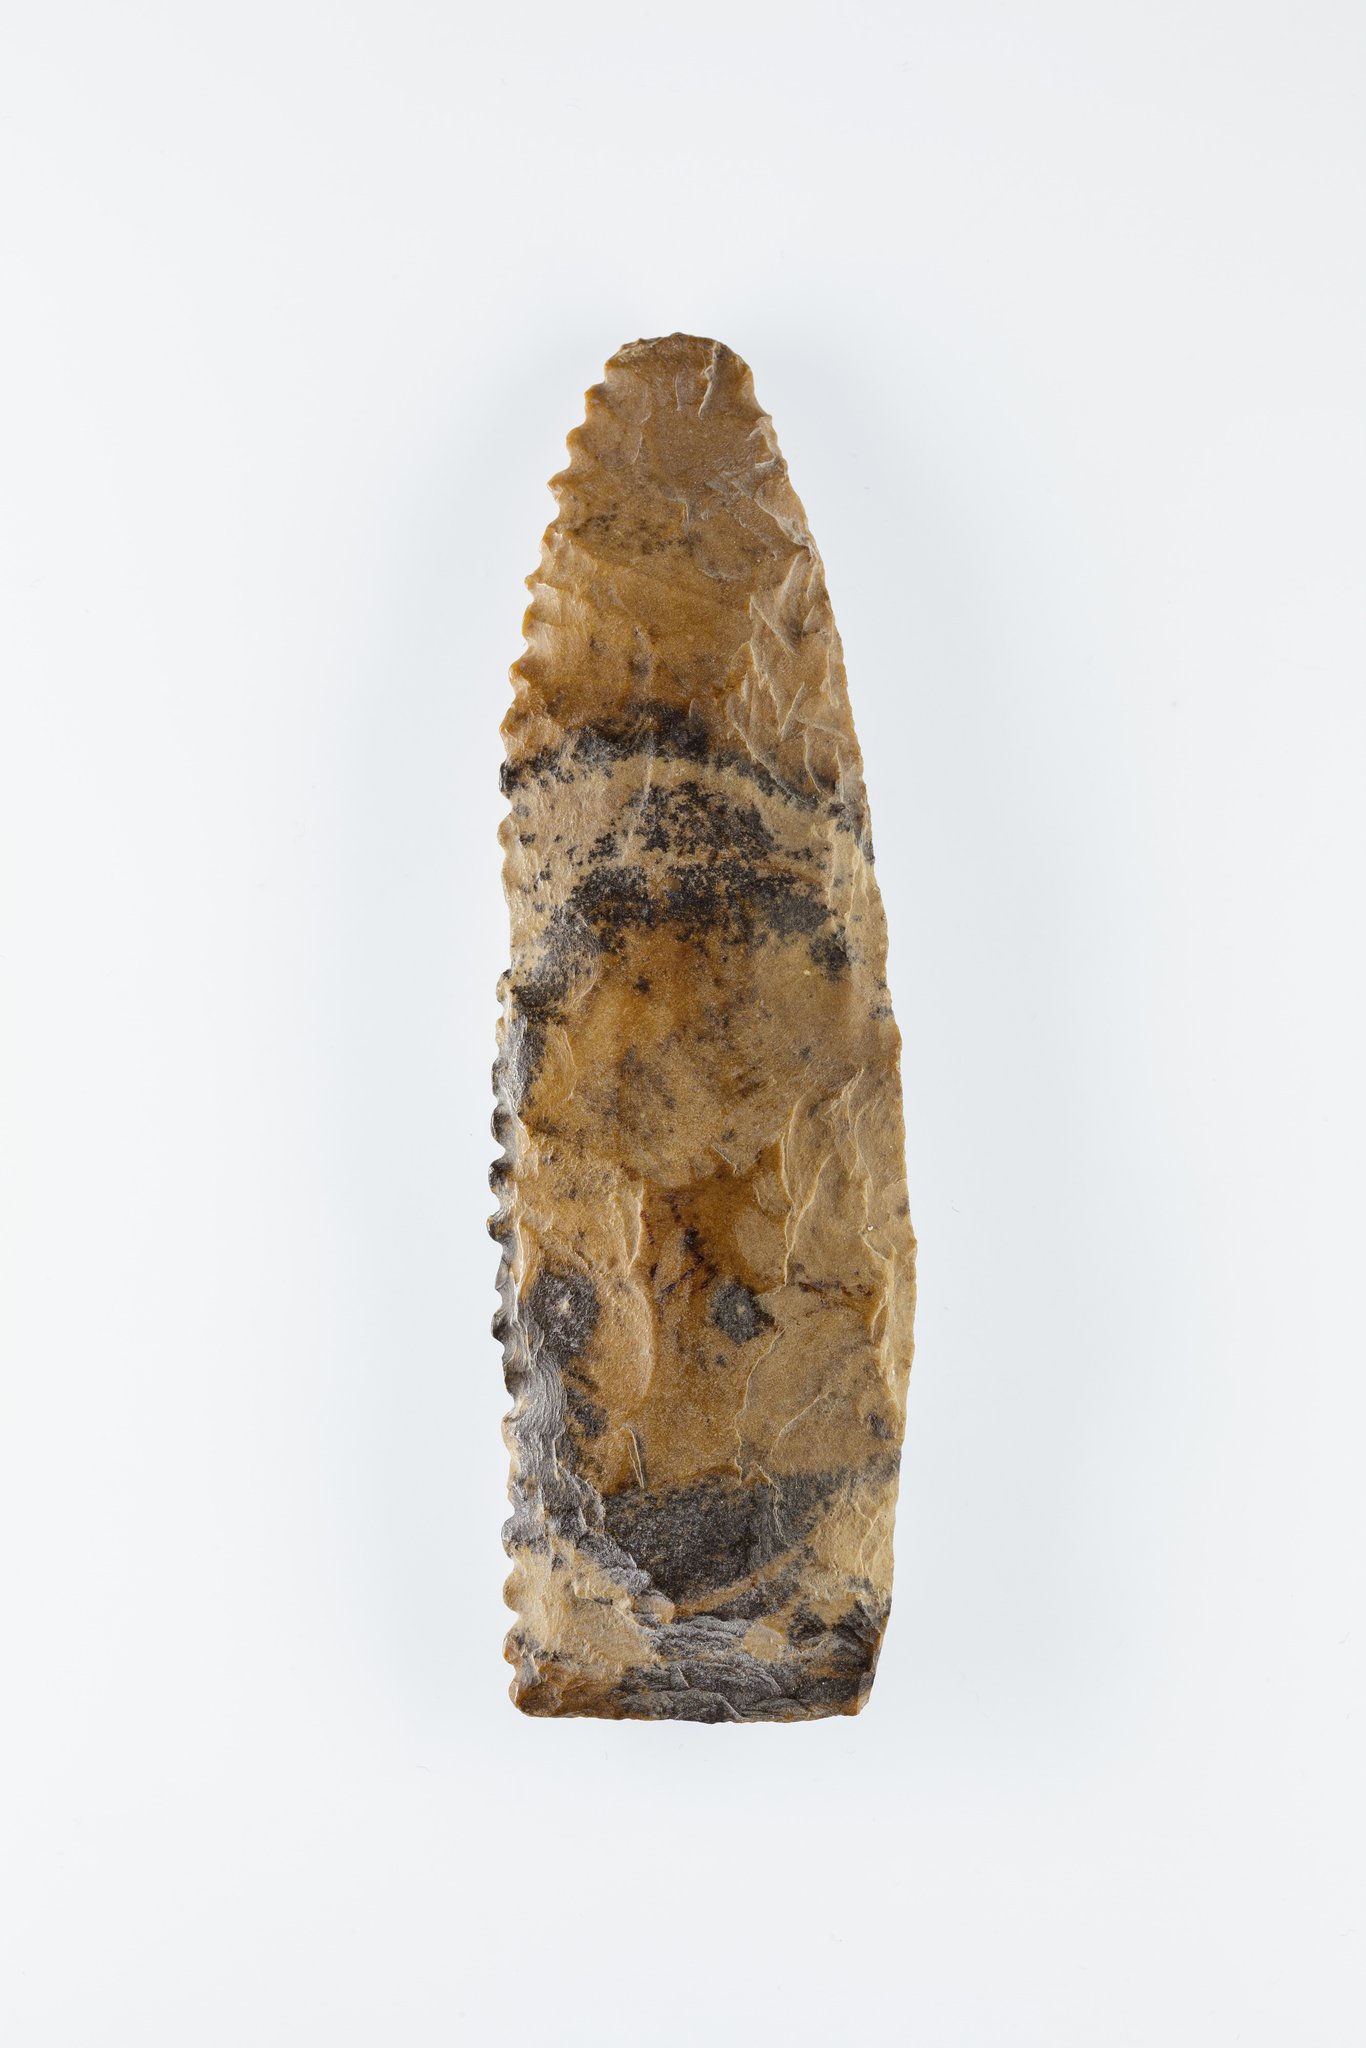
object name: sickle, insert, denticulate, bifacial, tool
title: Bifacial Sickle Insert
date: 4500-4000 BCE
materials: stone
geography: egypt